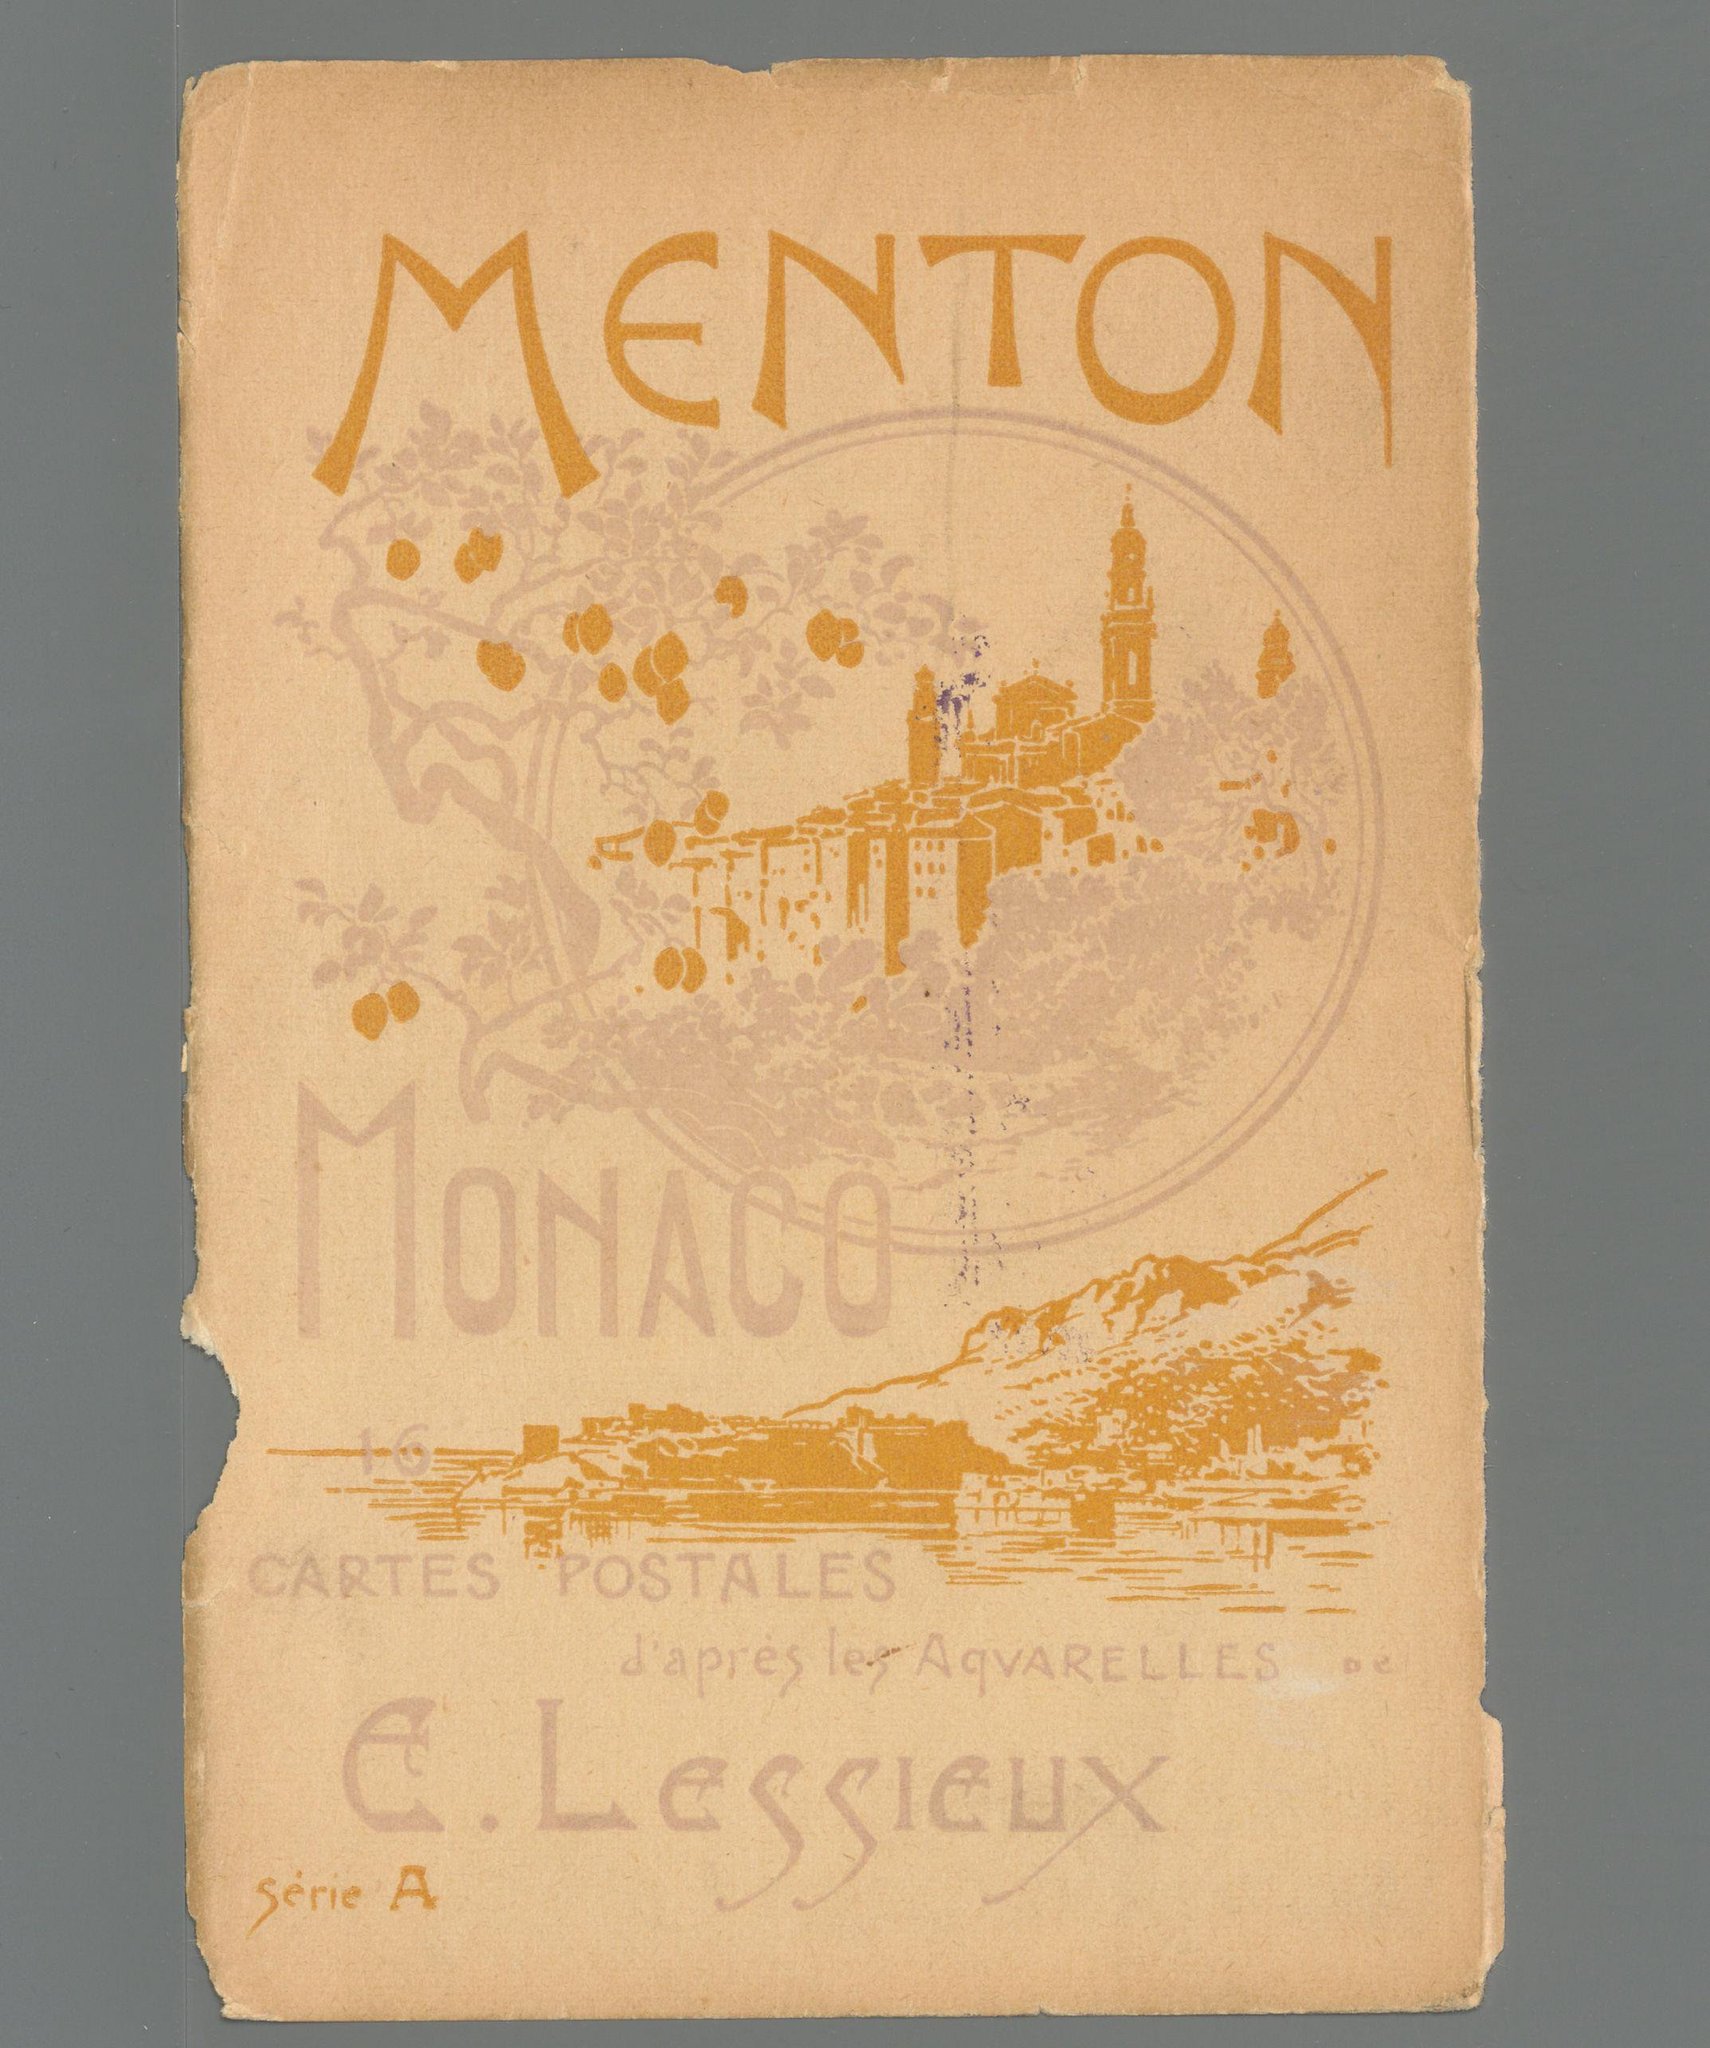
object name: wrapper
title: Menton, Monaco. 16 Cartes Postales d'après les aquarelles de E. Lessieux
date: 1892-1904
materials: cardboard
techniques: printing block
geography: paris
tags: landscapes in the temperate zone, rocky coast, church (exterior)